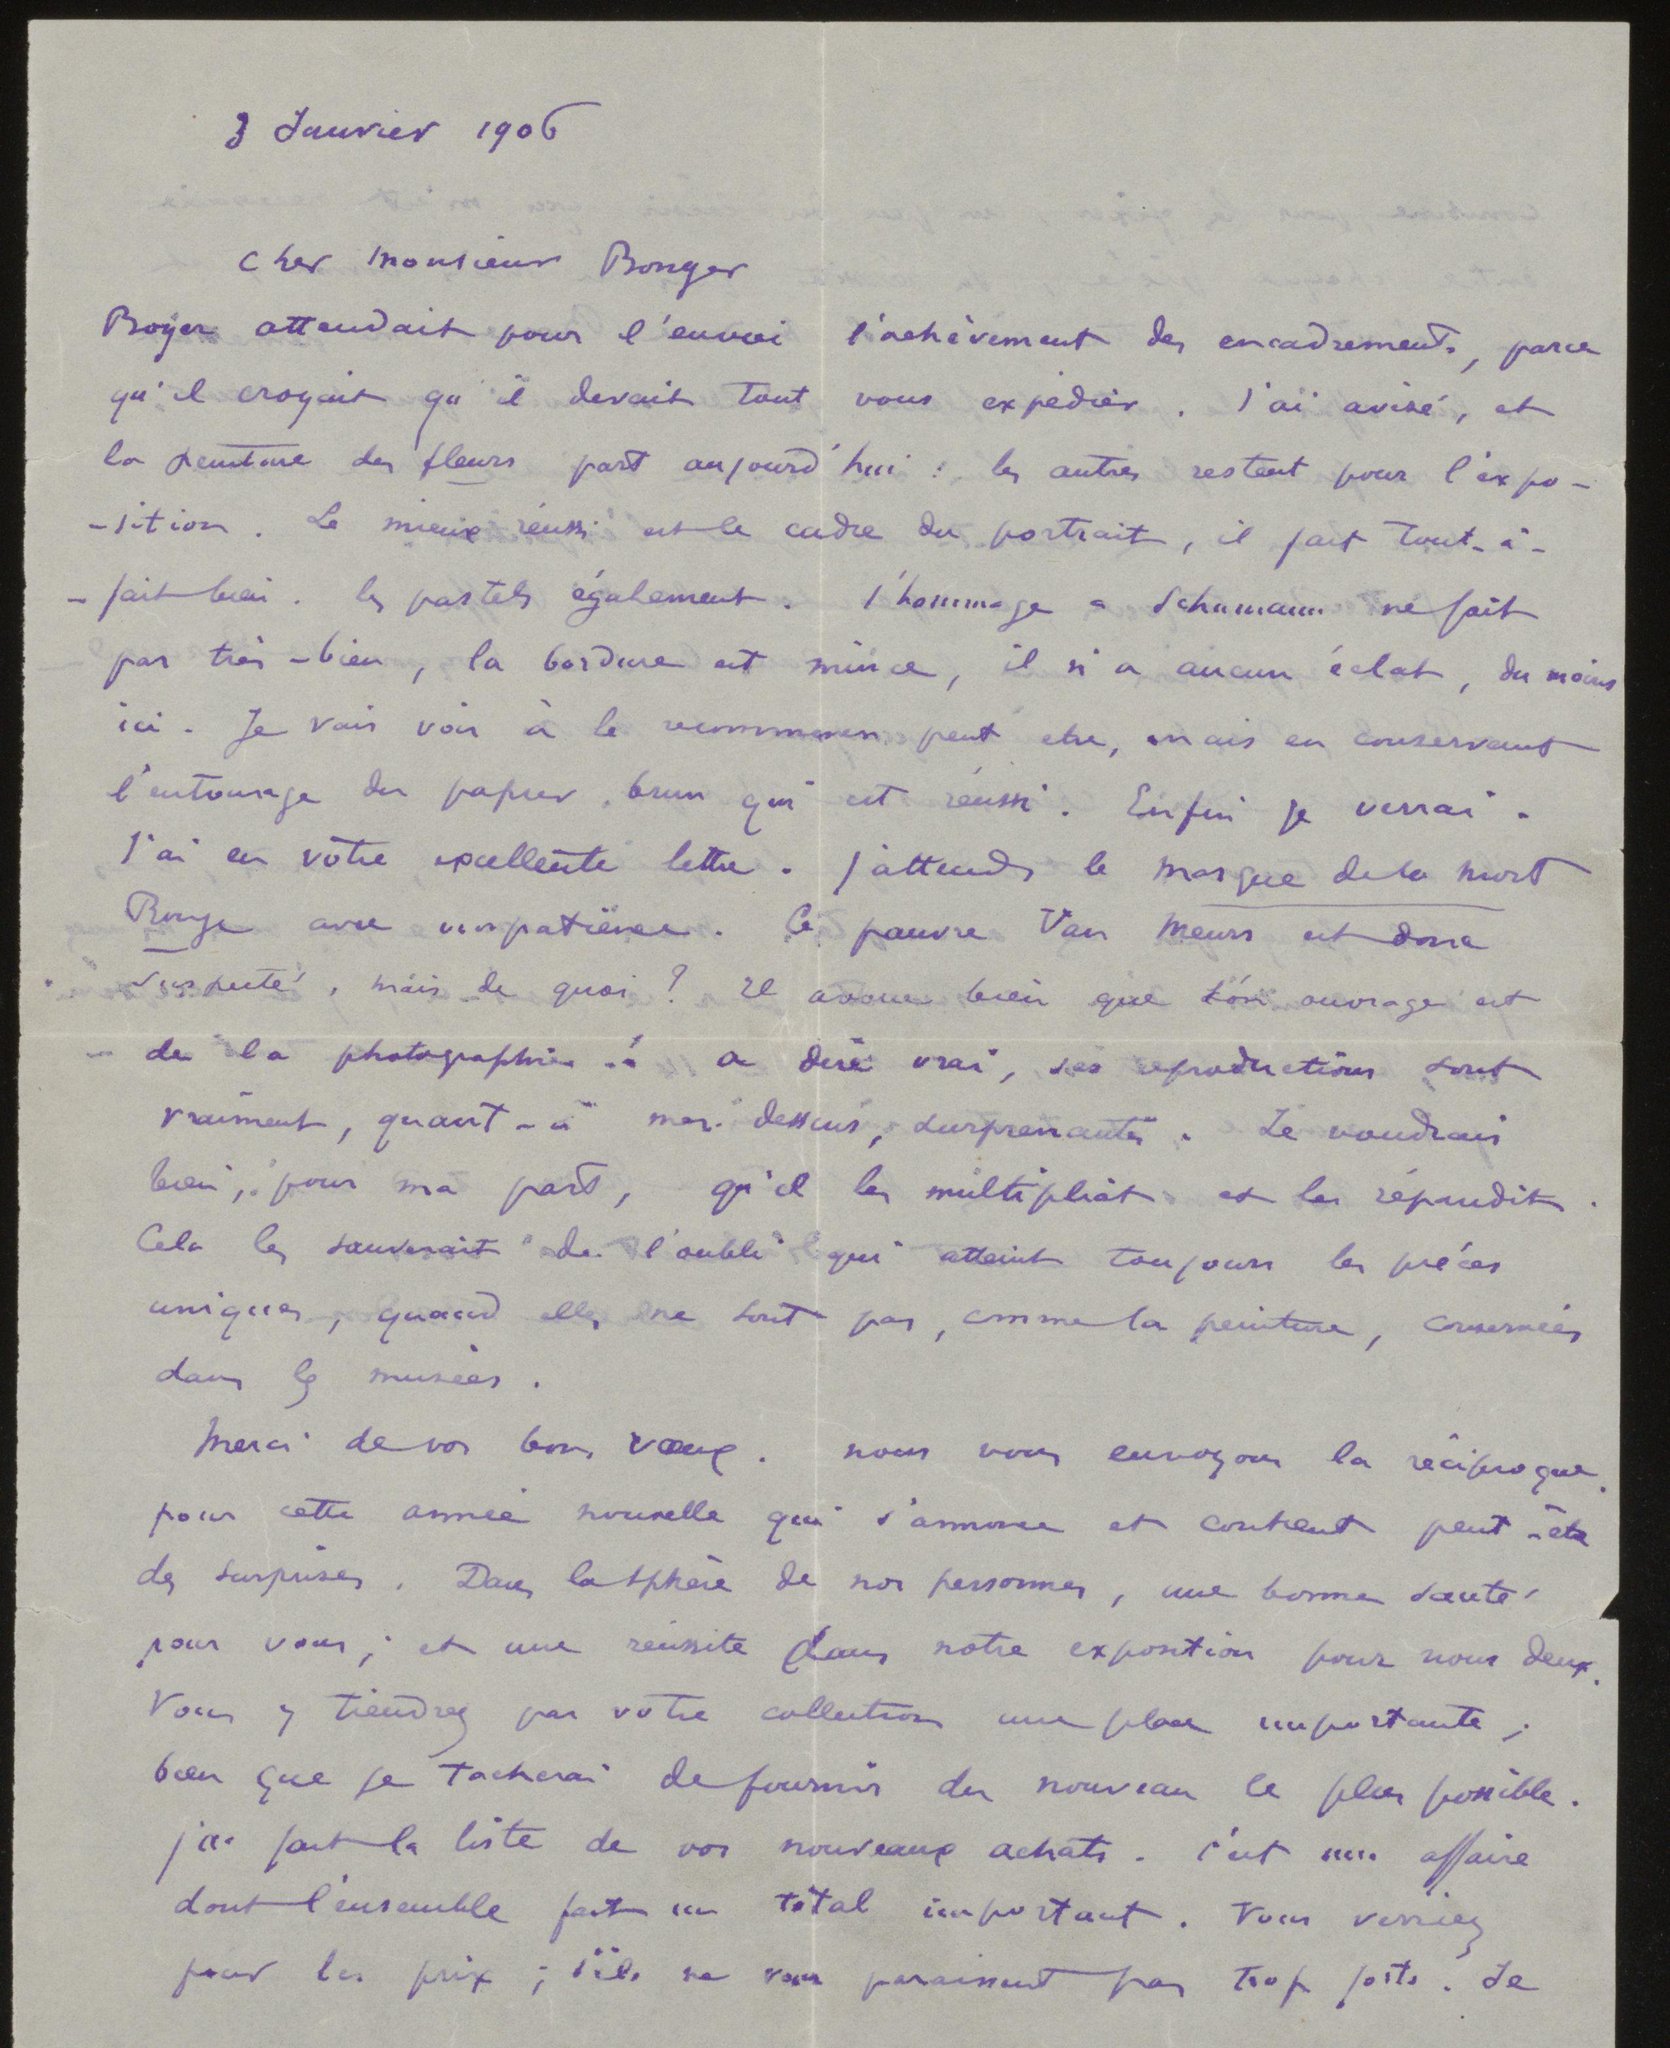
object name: letter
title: Brief aan Andries Bonger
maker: odilon redon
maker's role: draughtsman, painter, print maker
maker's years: 1840-1916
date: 1906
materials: ink, paper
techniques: pen, writing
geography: paris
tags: publisher, amsterdam, andries bonger, drawing, photography, cinematography, exhibition ~ art, art collecting, historical persons (portraits and scenes from the life), money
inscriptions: watermark